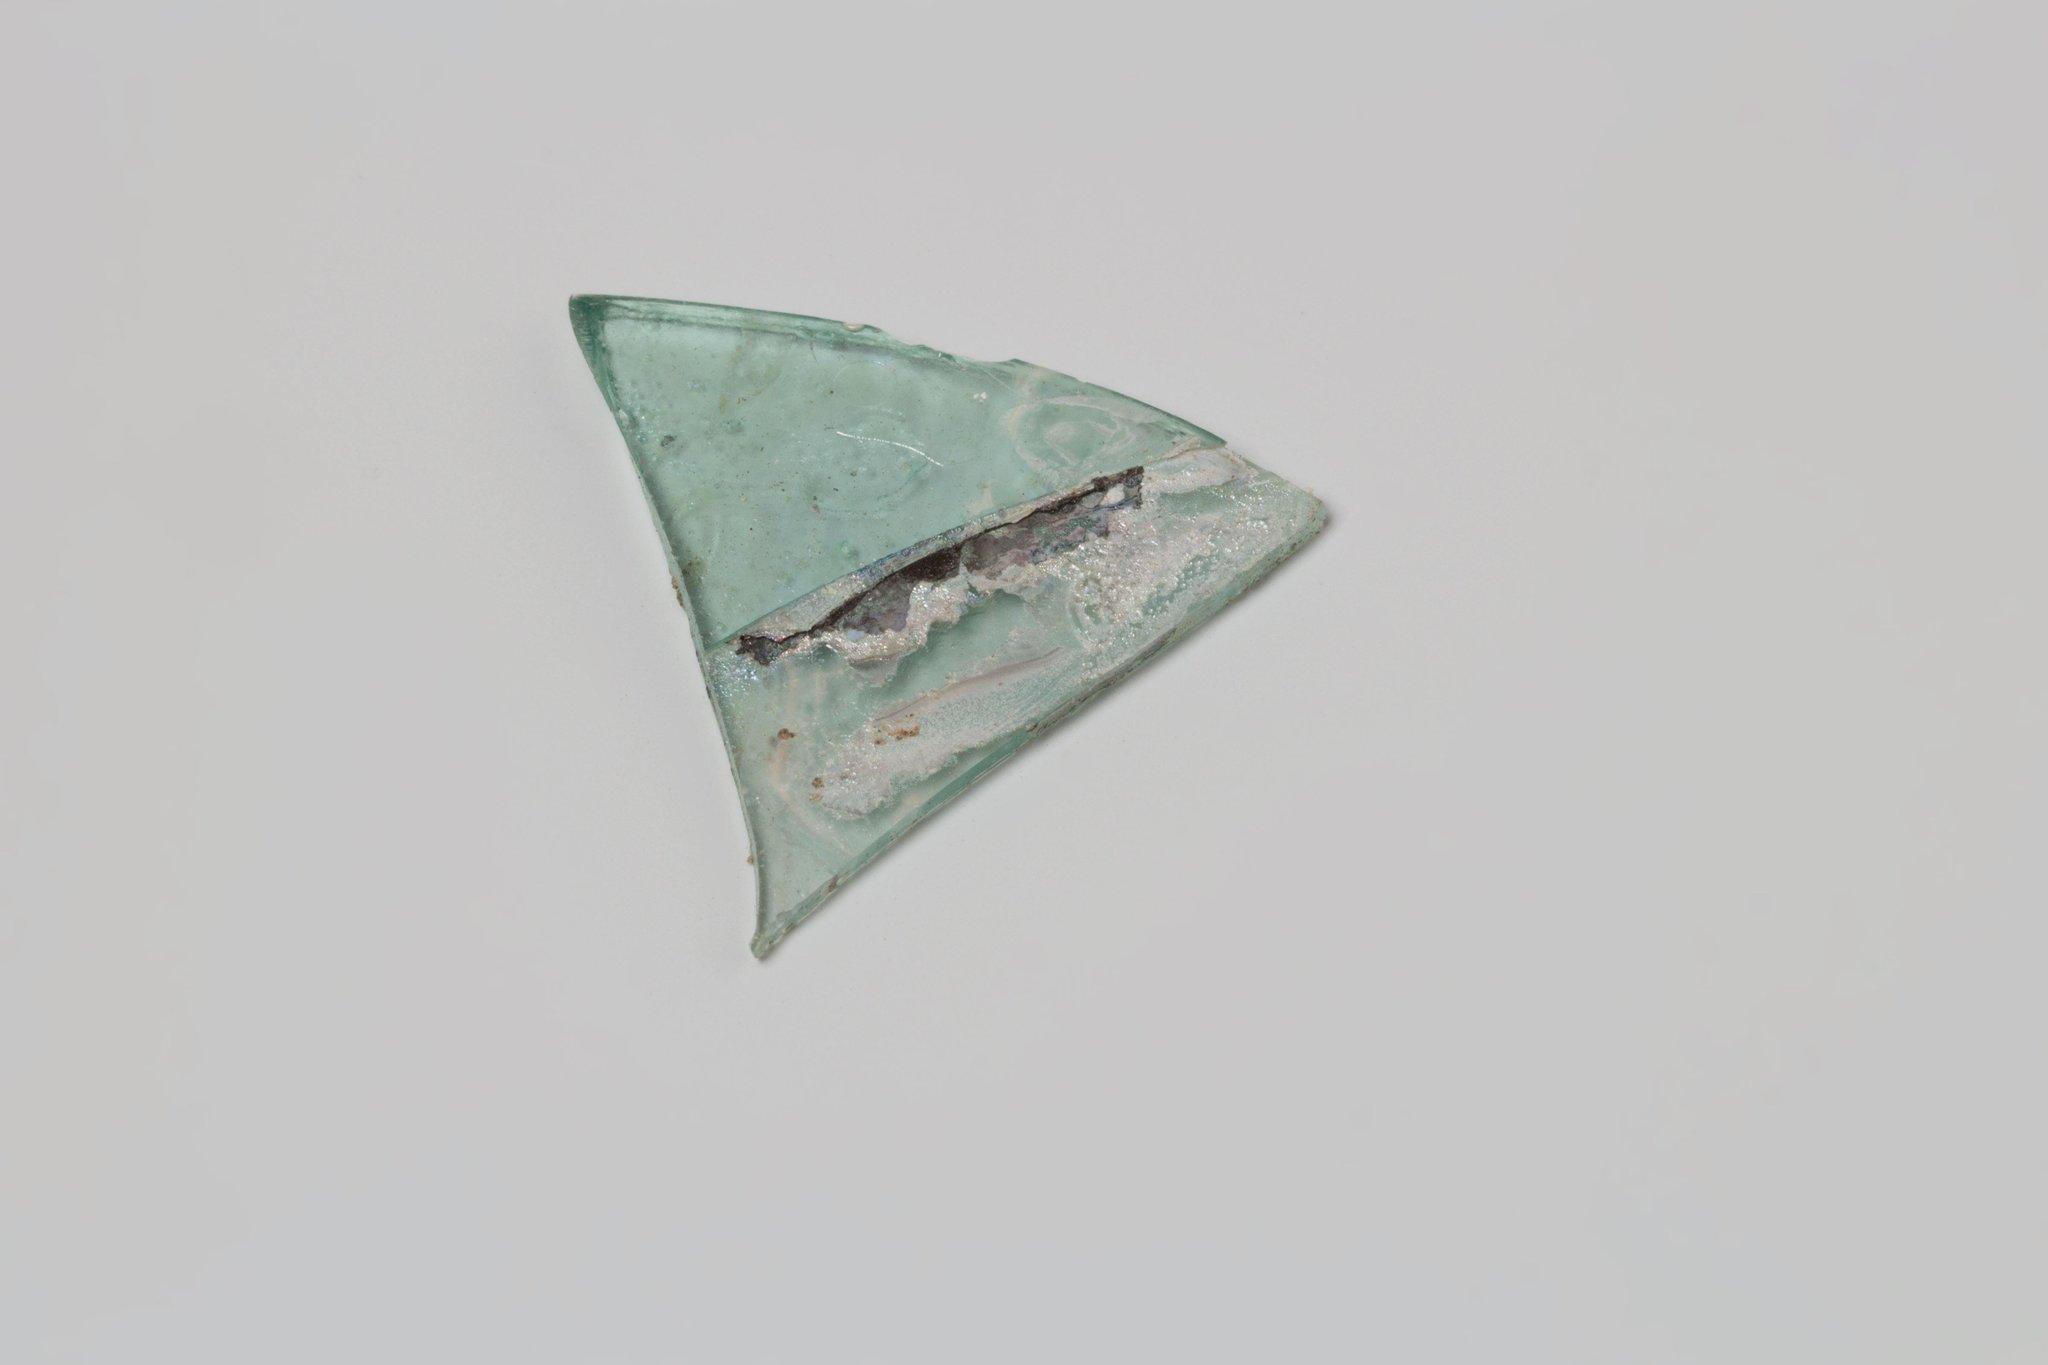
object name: lantern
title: Glasscherf van een kelderfles, vensterruitje of lantaarn uit het wrak van de in 1735 vergane Oost-Indiëvaarder 't Vliegend Hart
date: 1700-1735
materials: glass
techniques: green glass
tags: 't vliegend hart (schip), verenigde oostindische compagnie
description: Het transparant-groene, vrij platte glasfragment is driehoekig en aan een kant geschilferd. Missschien, gezien de platheid, heeft het ooit deel uitgemaakt van een kelderfles, vensterruitje of een lantaarn.